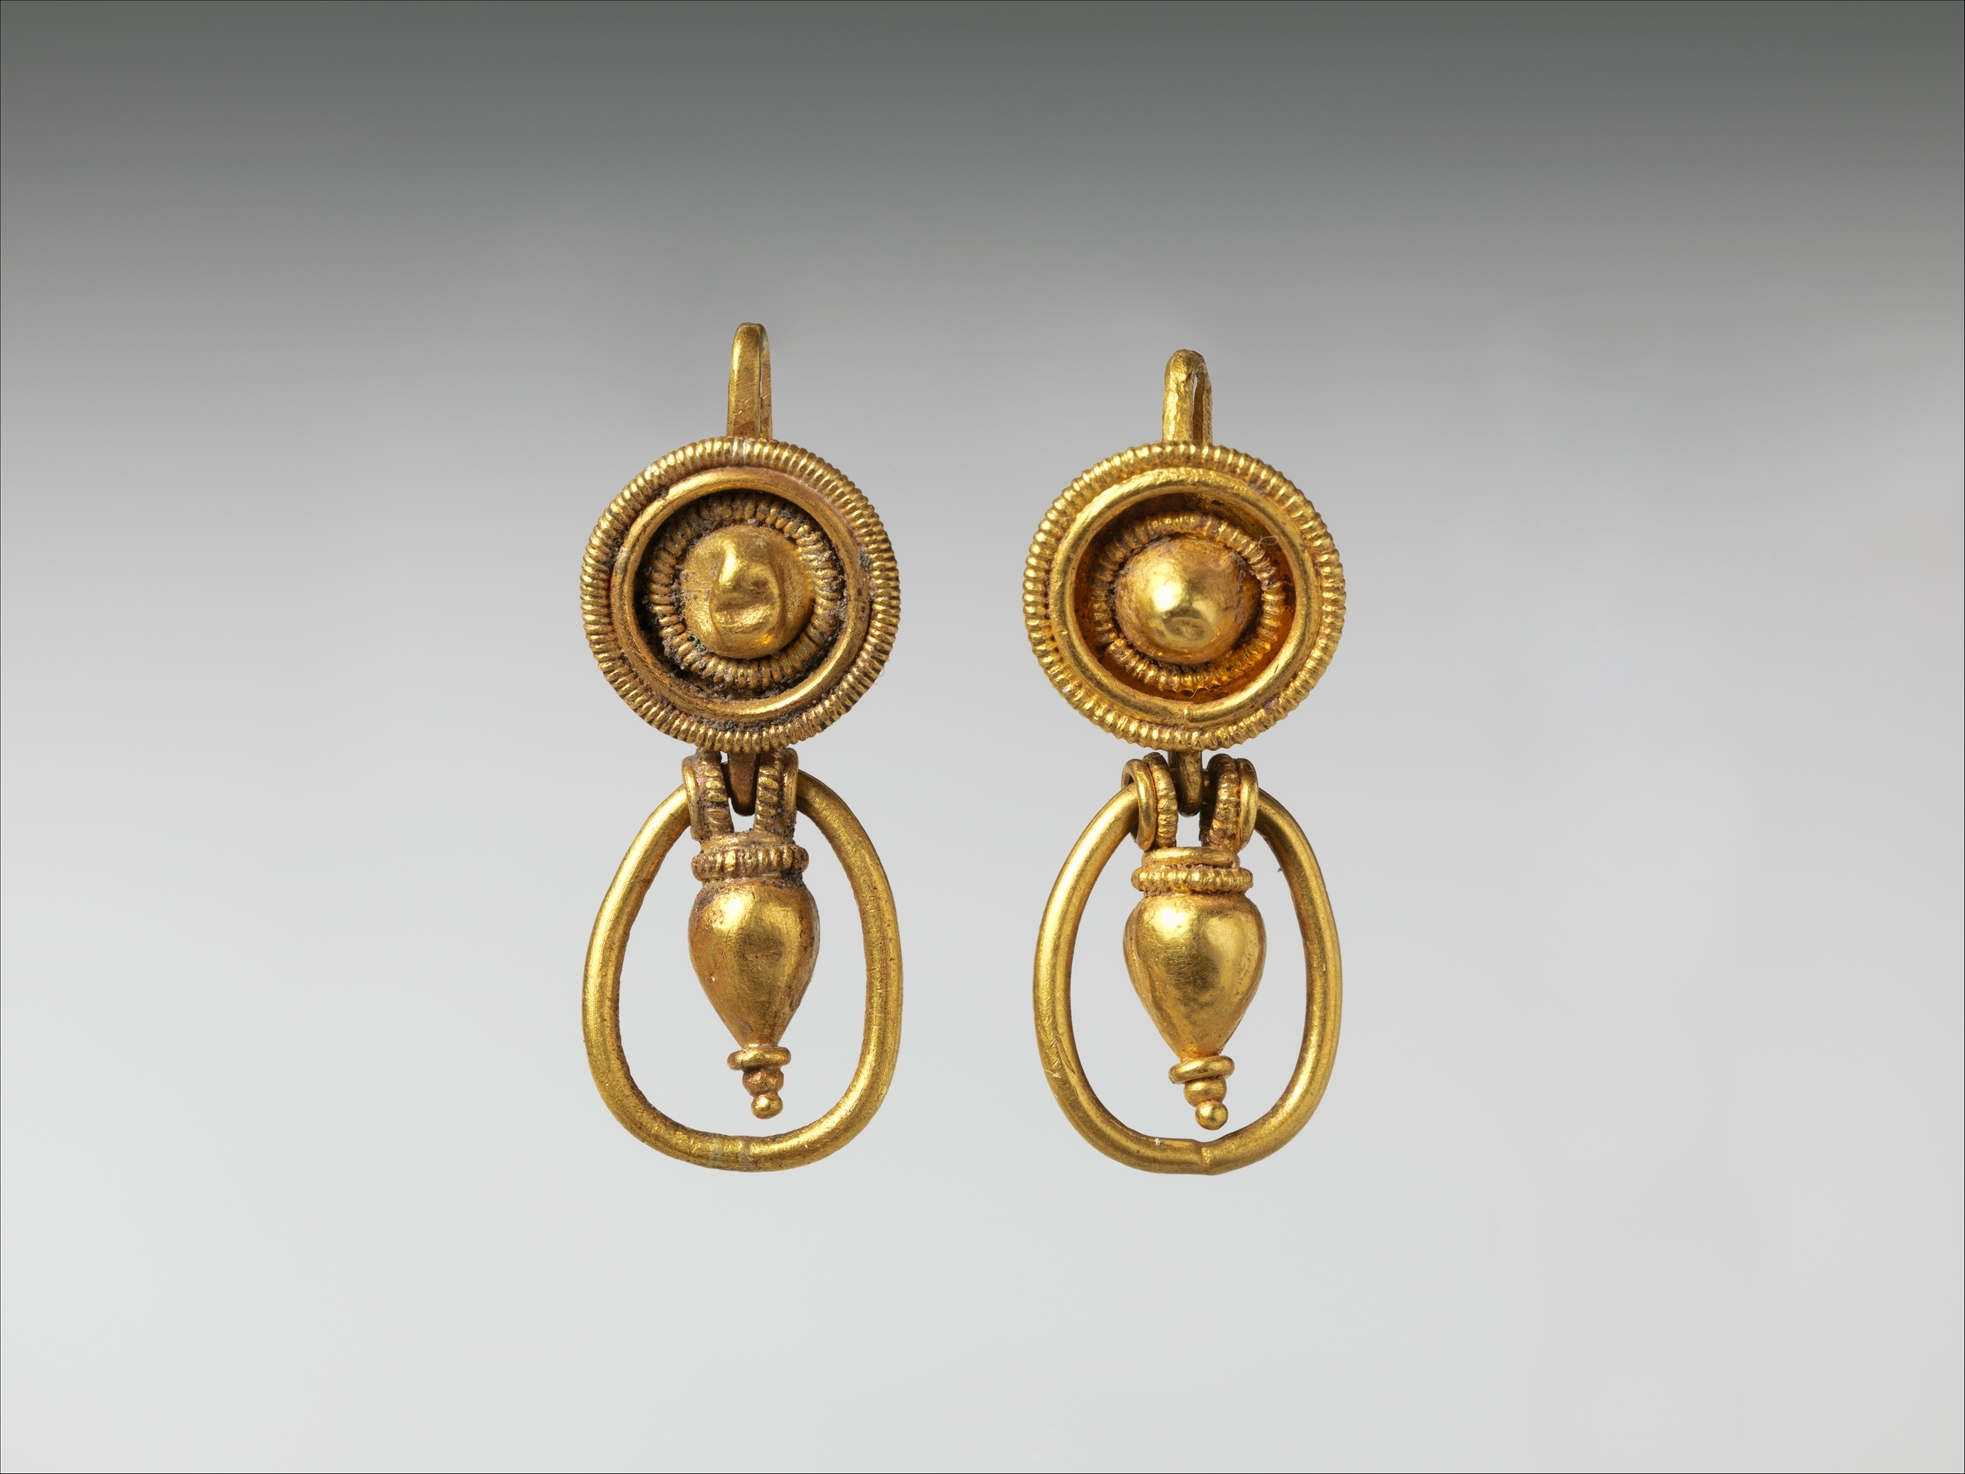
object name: earring with rosette and amphora pendant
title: Gold earrings with pendant vase and ring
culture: etruscan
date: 400-301 BCE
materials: gold